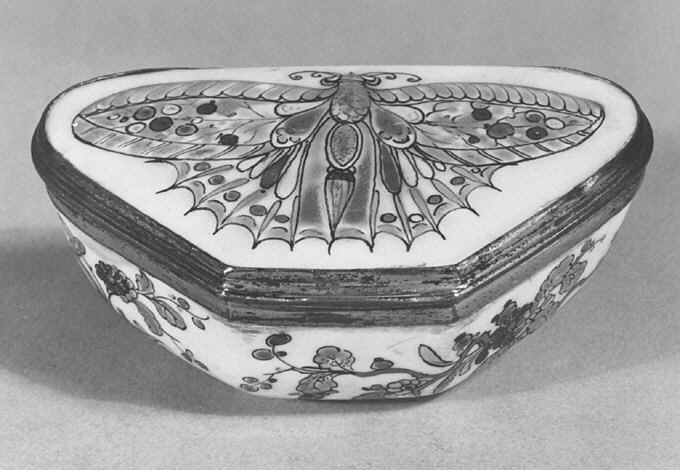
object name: snuffbox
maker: saint-cloud factory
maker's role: factory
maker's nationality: french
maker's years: 1693-1766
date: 1740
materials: copper gilt, soft paste porcelain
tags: butterflies,flowers